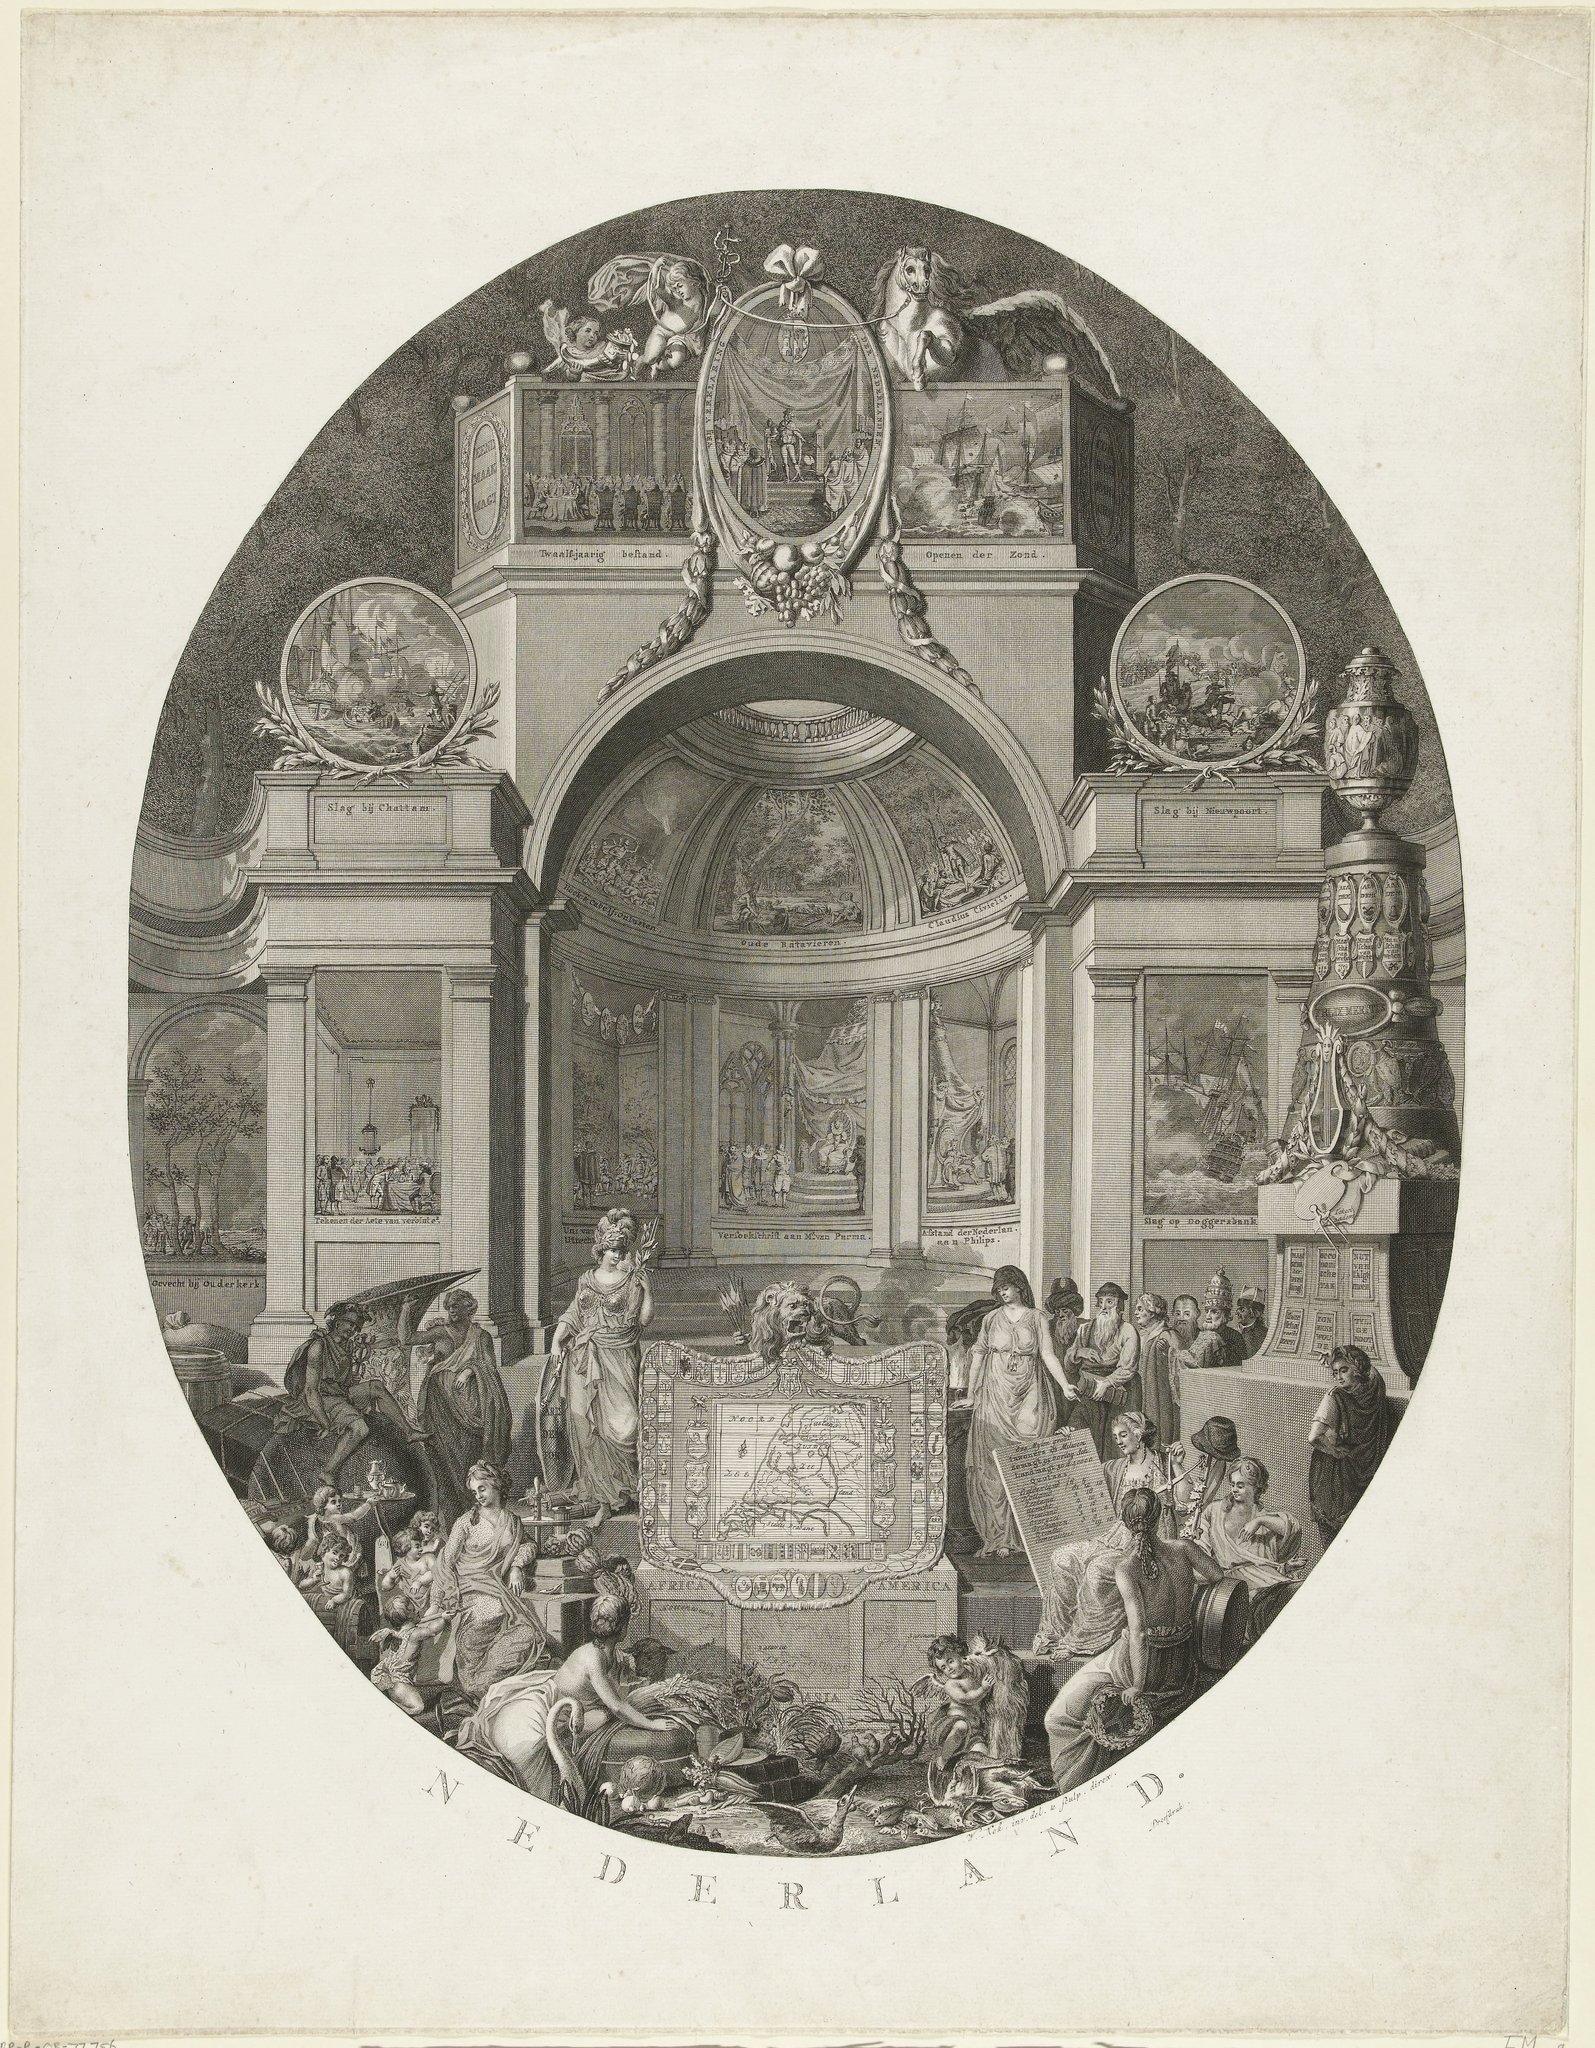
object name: print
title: Allegorie op de roemrijke geschiedenis van Nederland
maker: willem kok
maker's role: draughtsman, print maker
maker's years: 1761-1807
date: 1790-1807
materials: paper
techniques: etching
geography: netherlands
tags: symbols of the state (in general)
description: Ovale voorstelling van het interieur van een tempel waarin de geschiedenis van Nederland uitgebreid verheerlijkt wordt.